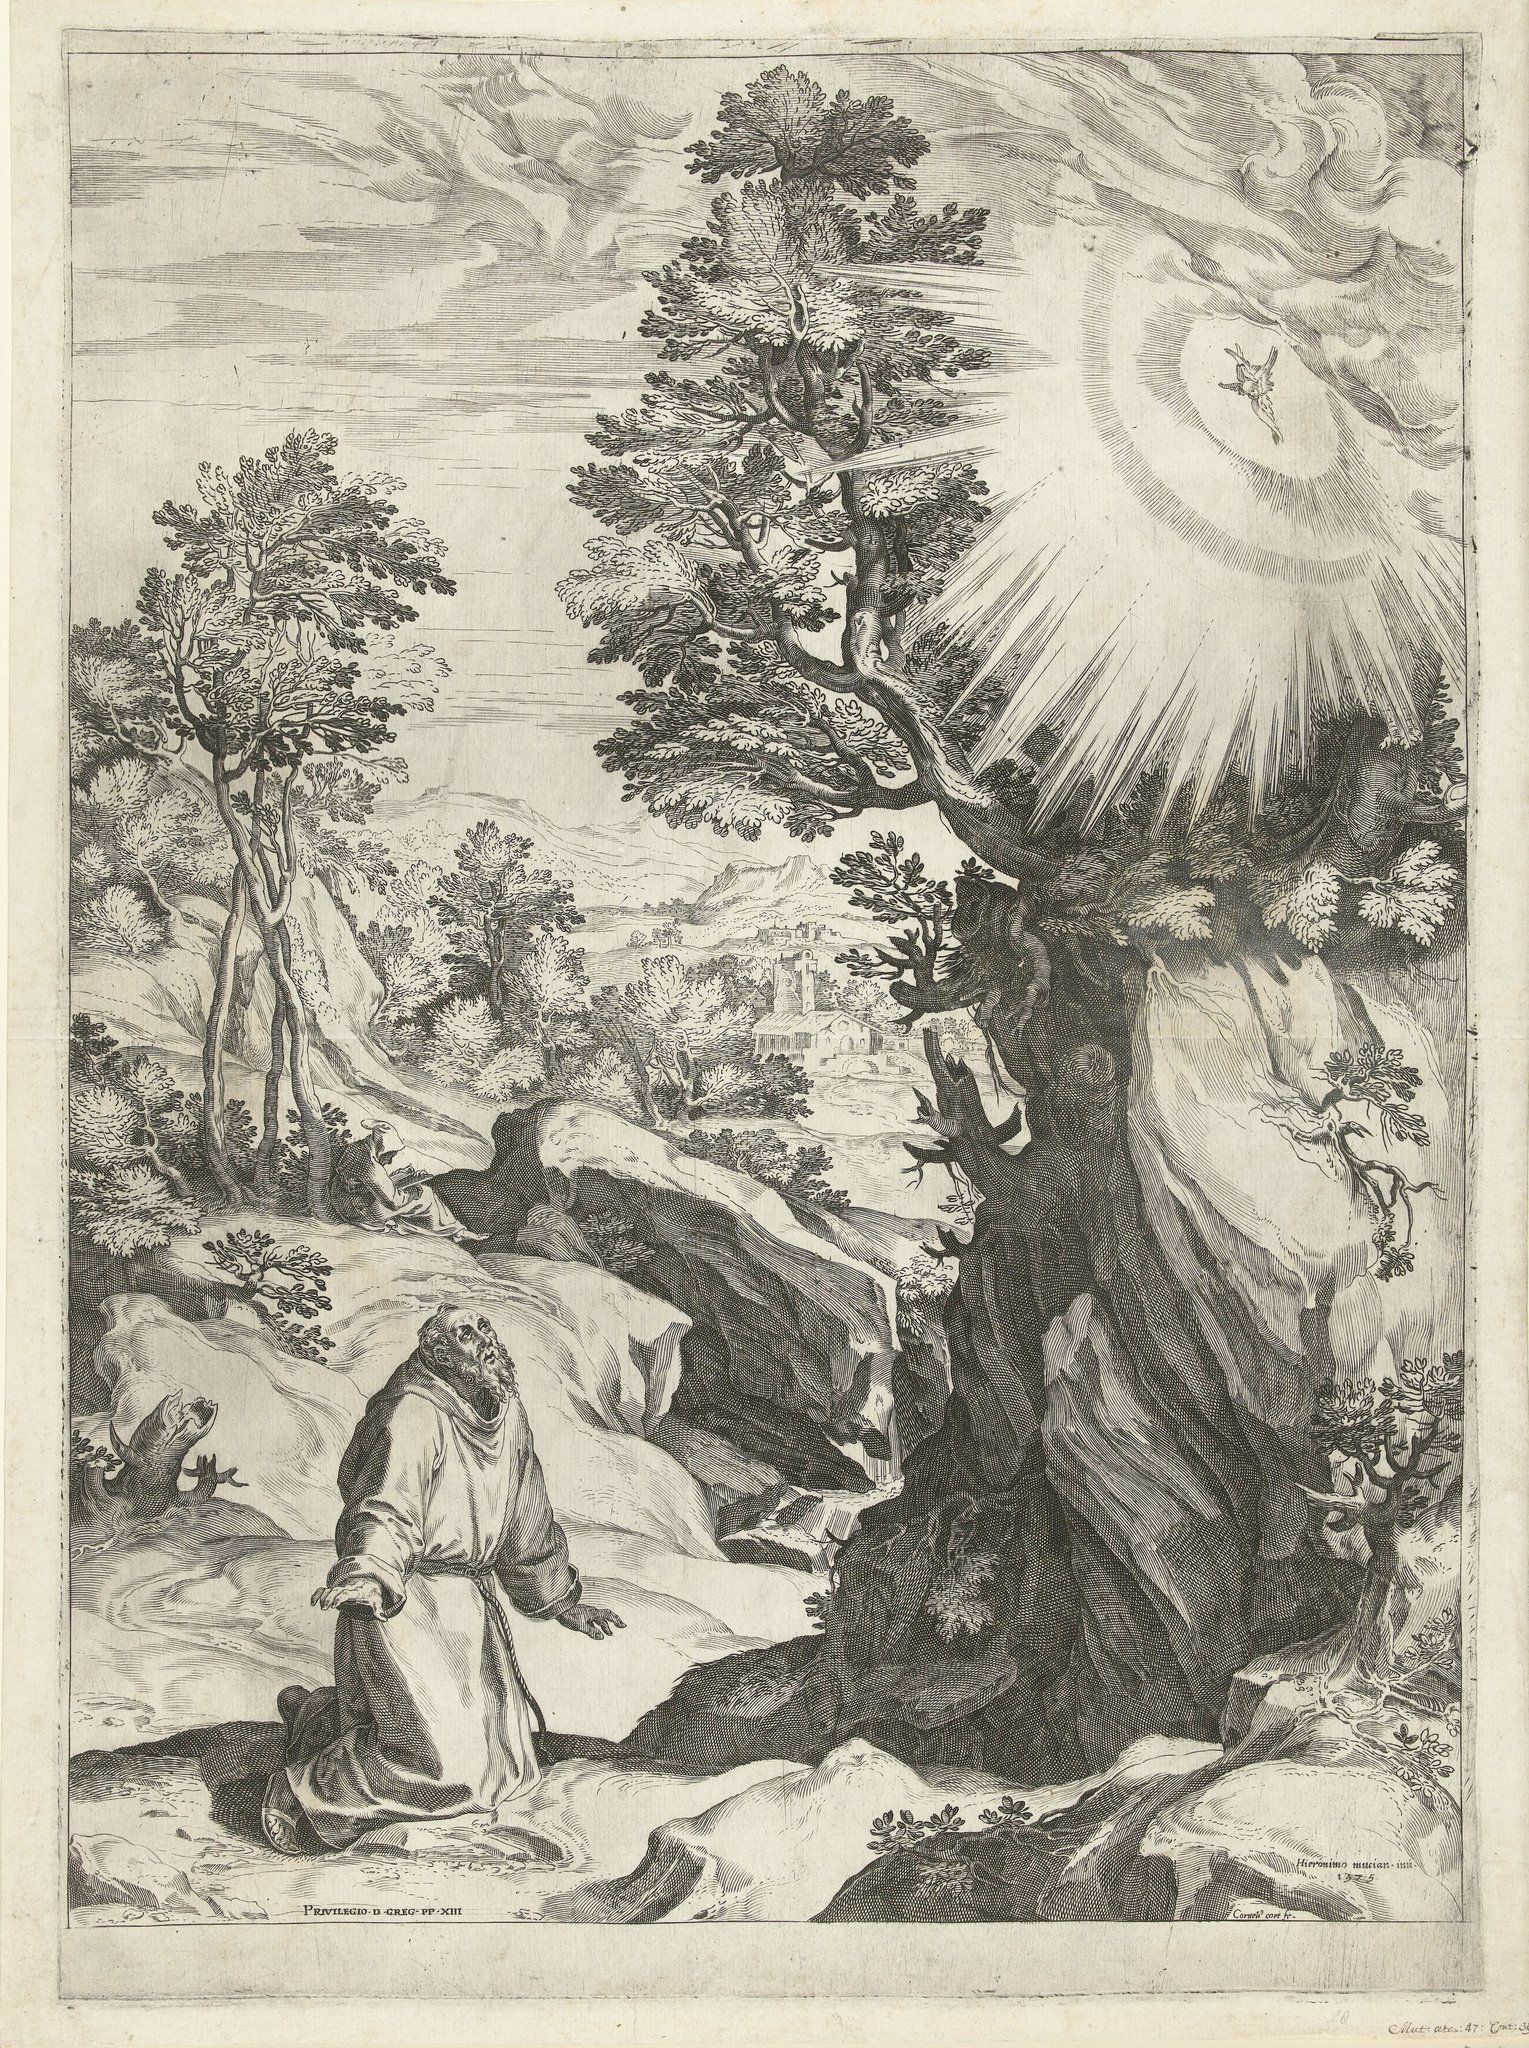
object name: print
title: Landschap met het visioen van de H. Franciscus van Assisi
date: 1575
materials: paper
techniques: engraving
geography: rome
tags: martyrdom, suffering, misfortune, death of st. francis of assisi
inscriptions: collector's mark: Lugt 240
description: Op de Monte Alverna heeft Franciscus een visioen van een serafijn met zes vleugels. Franciscus gekleed in een eenvoudige monnikspij knielt neer en kijkt naar de serafijn. Op de achtergrond een landschap met de San Damianokerk in Assisi.